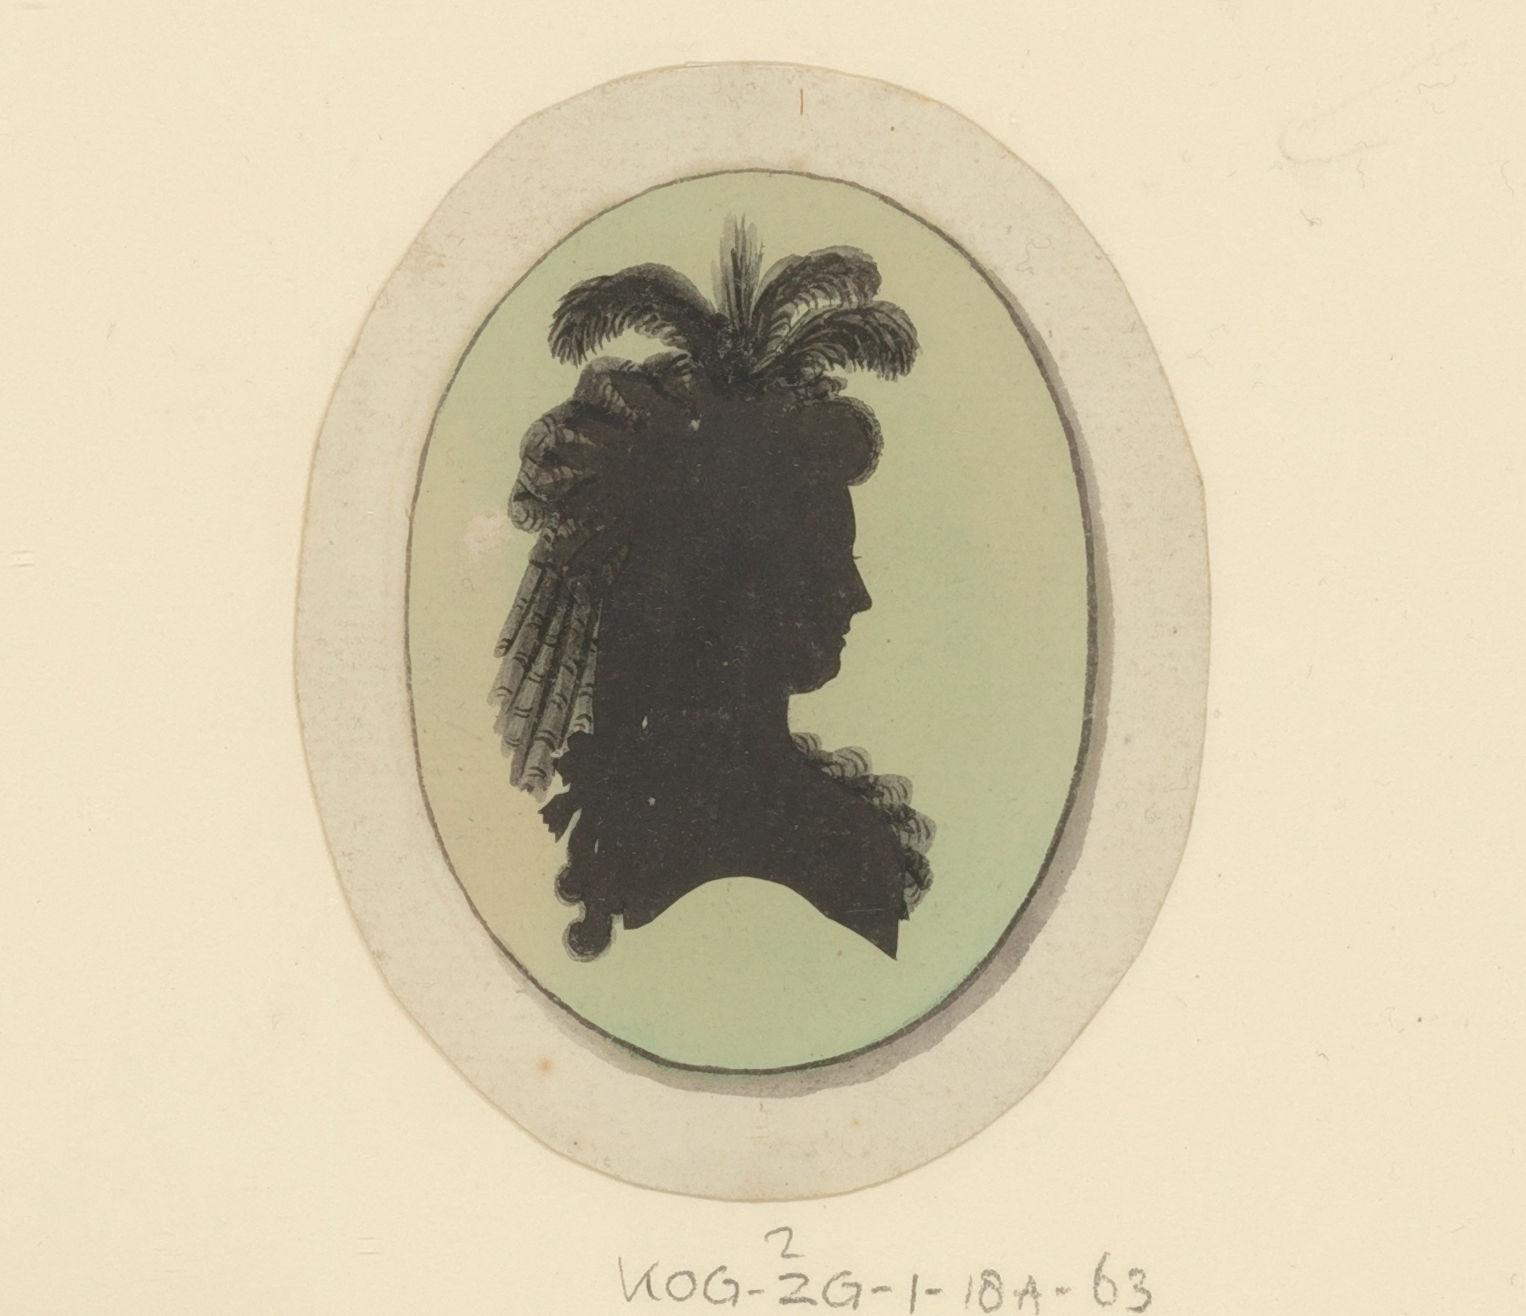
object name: silhouette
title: Silhouetportret van een onbekende vrouw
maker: joseph adolf schmetterling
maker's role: draughtsman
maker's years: 1751-1828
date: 1785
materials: paint, paper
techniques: brush, snipping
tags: historical persons - bb - woman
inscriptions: collector's mark: Lugt 1641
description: Borststuk van een dame en profil met in het haar een voile en drie veren. Onderwerpsrubrieken binnen de Atlas Zeden en Gewoonten: Schoone kunsten, Silhouetportretten.